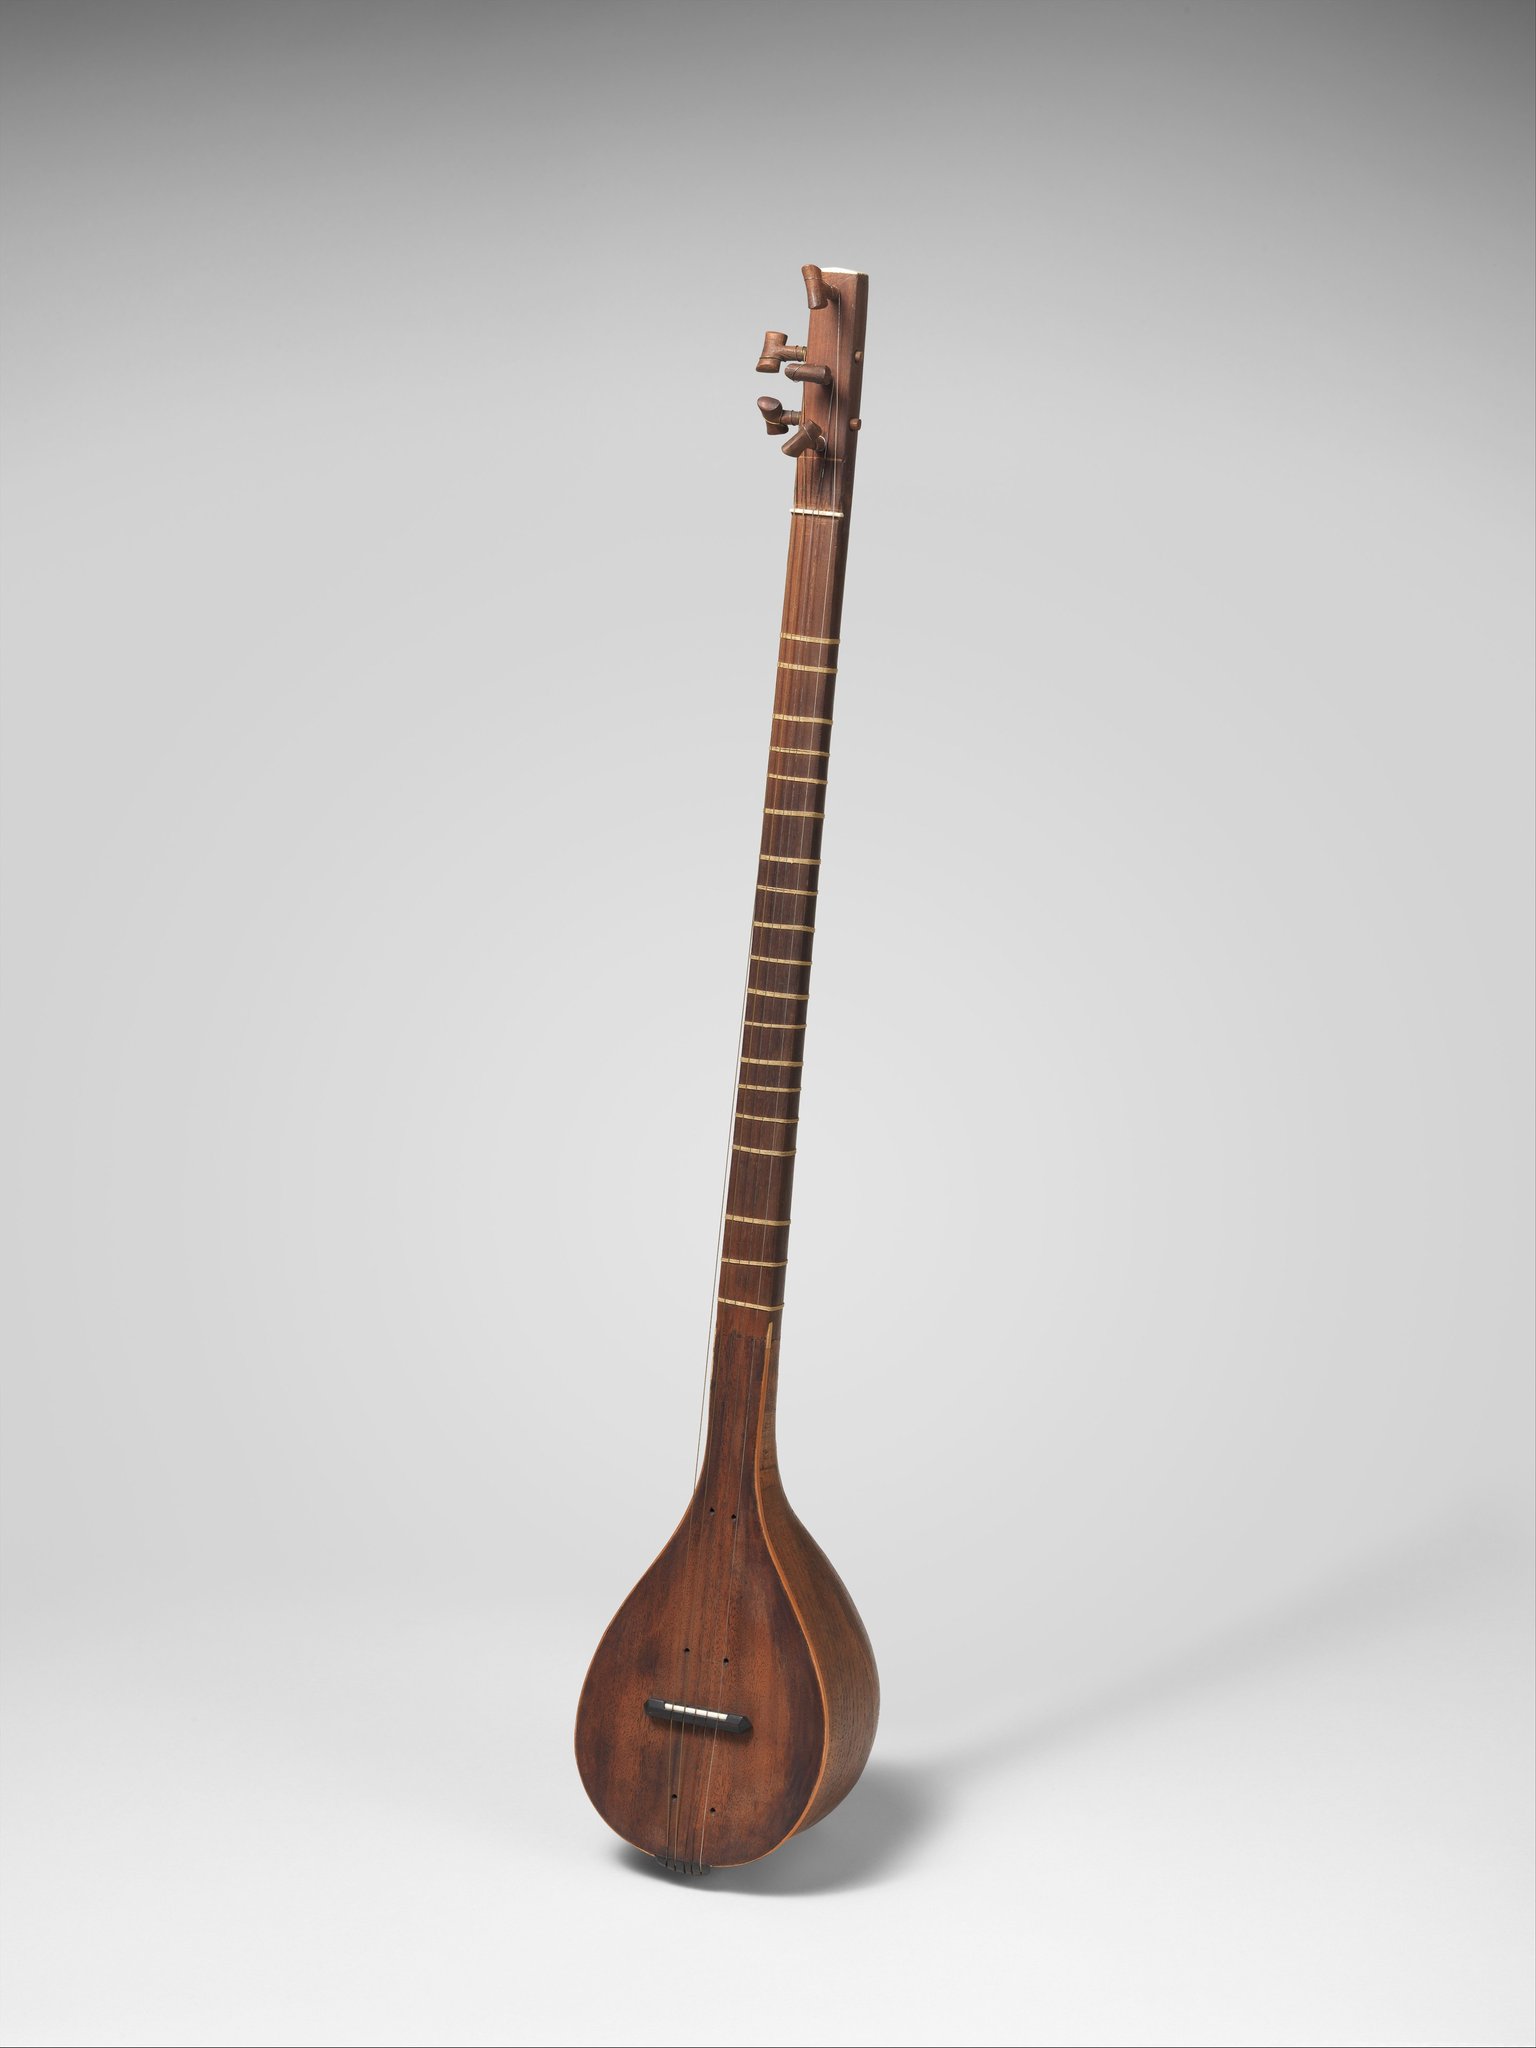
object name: setar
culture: iranian or persian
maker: hāj tāher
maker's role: maker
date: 1801-1900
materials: bone, metal, wood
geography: iran